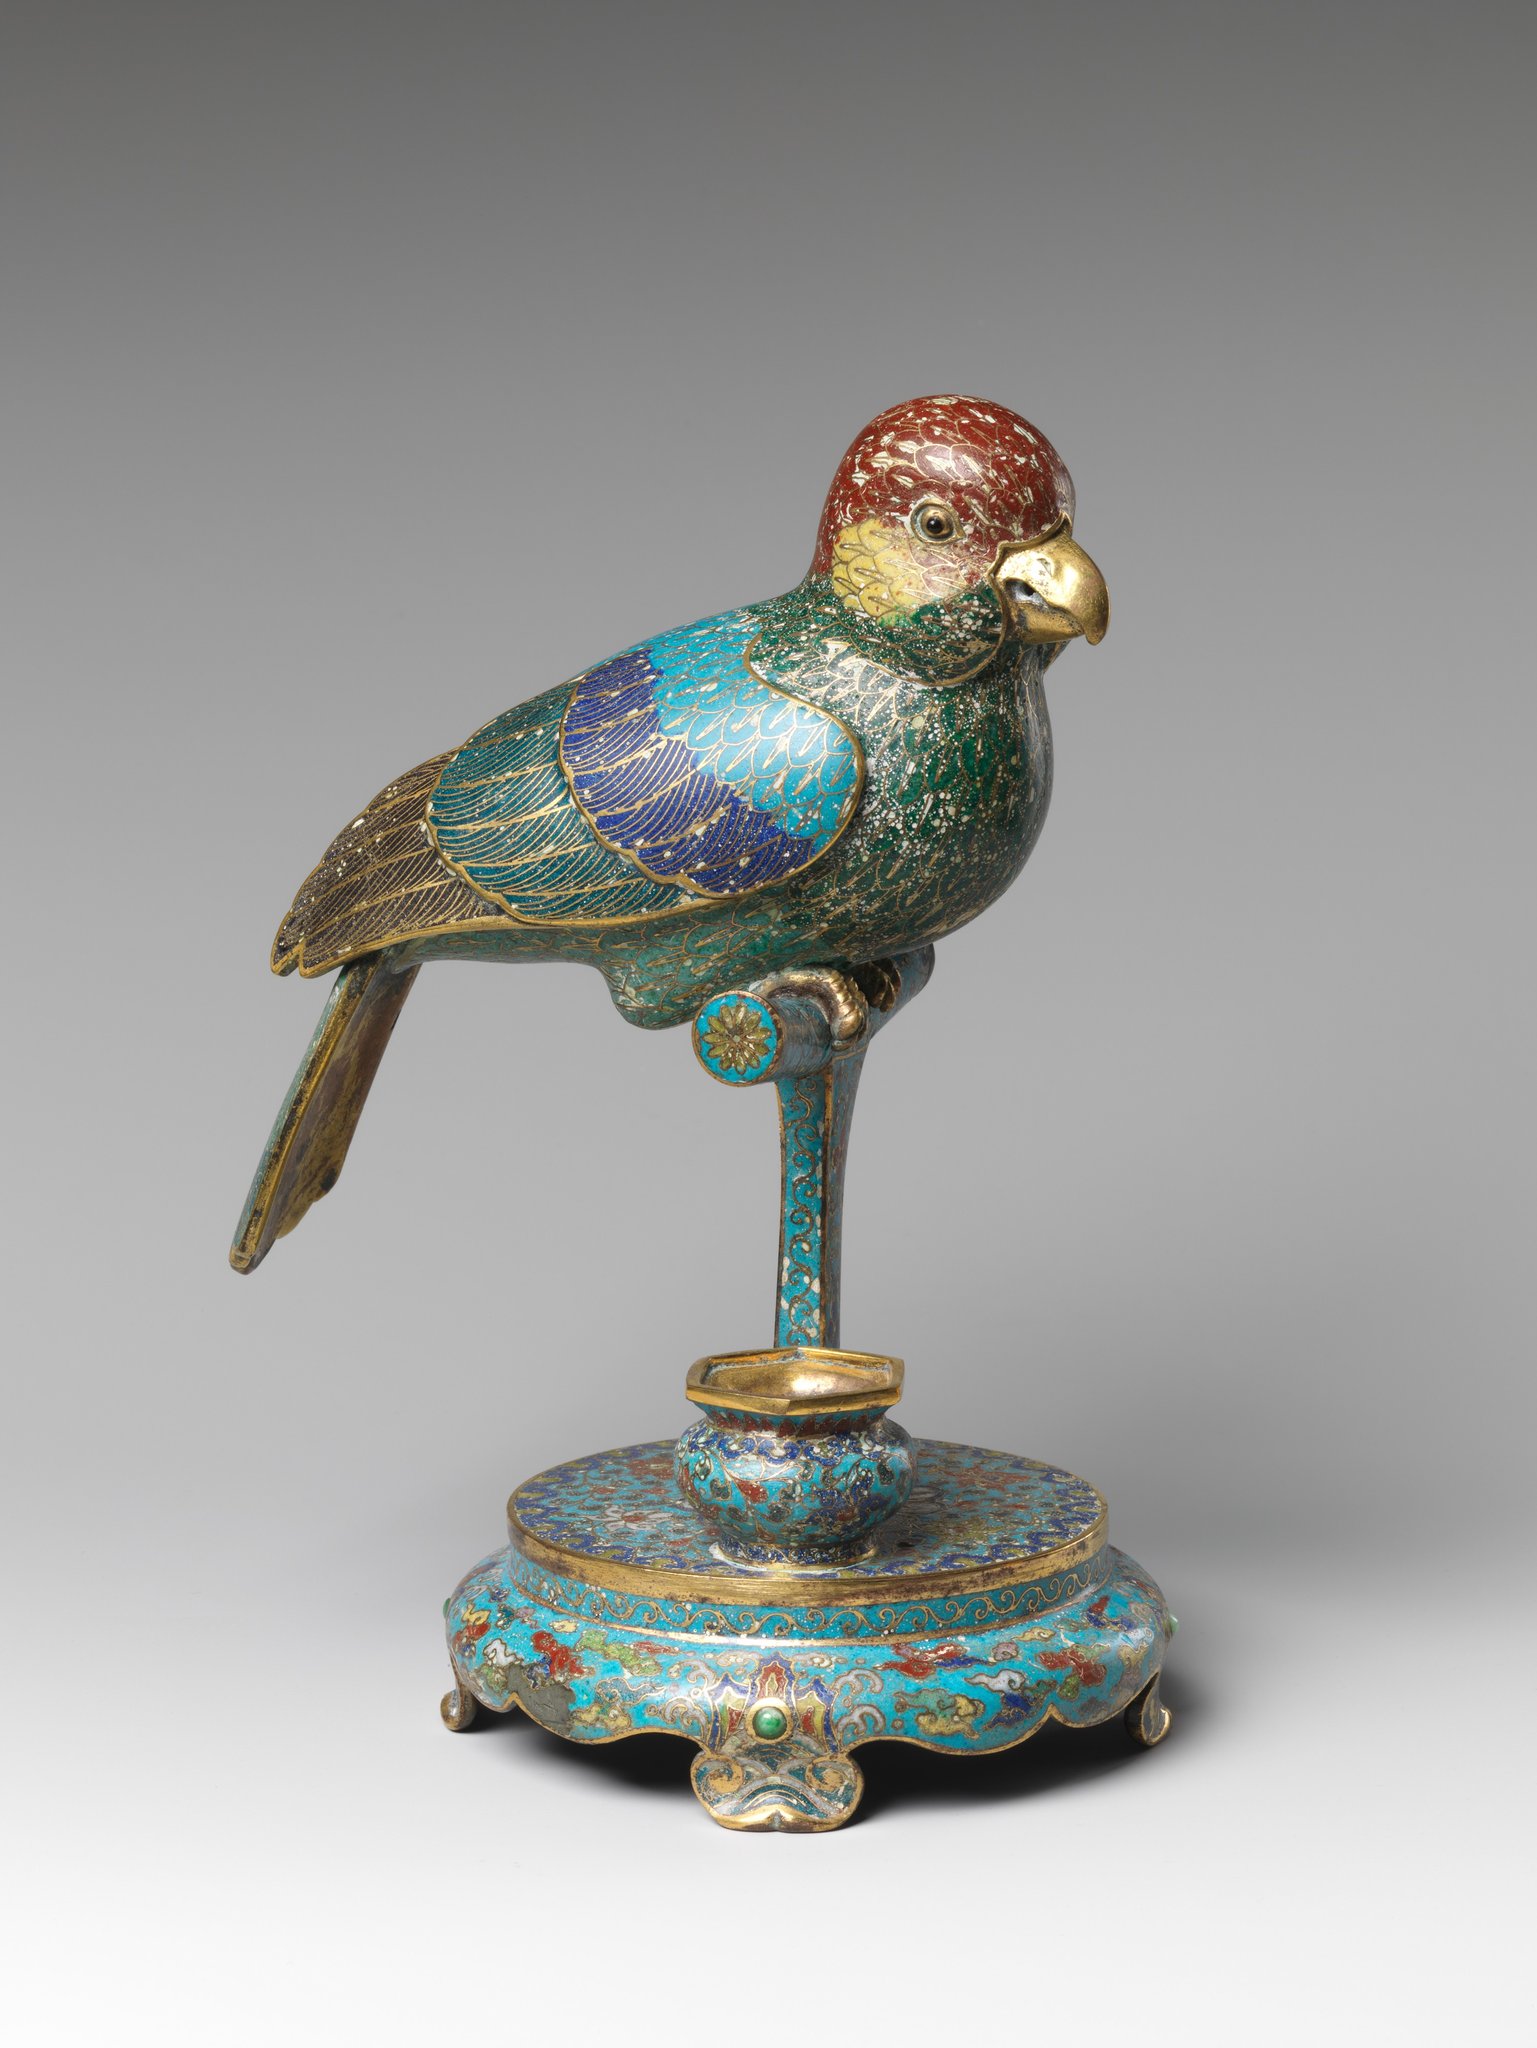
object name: parakeet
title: One of a pair of parakeets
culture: chinese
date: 1734-1766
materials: enamel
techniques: enamel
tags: birds